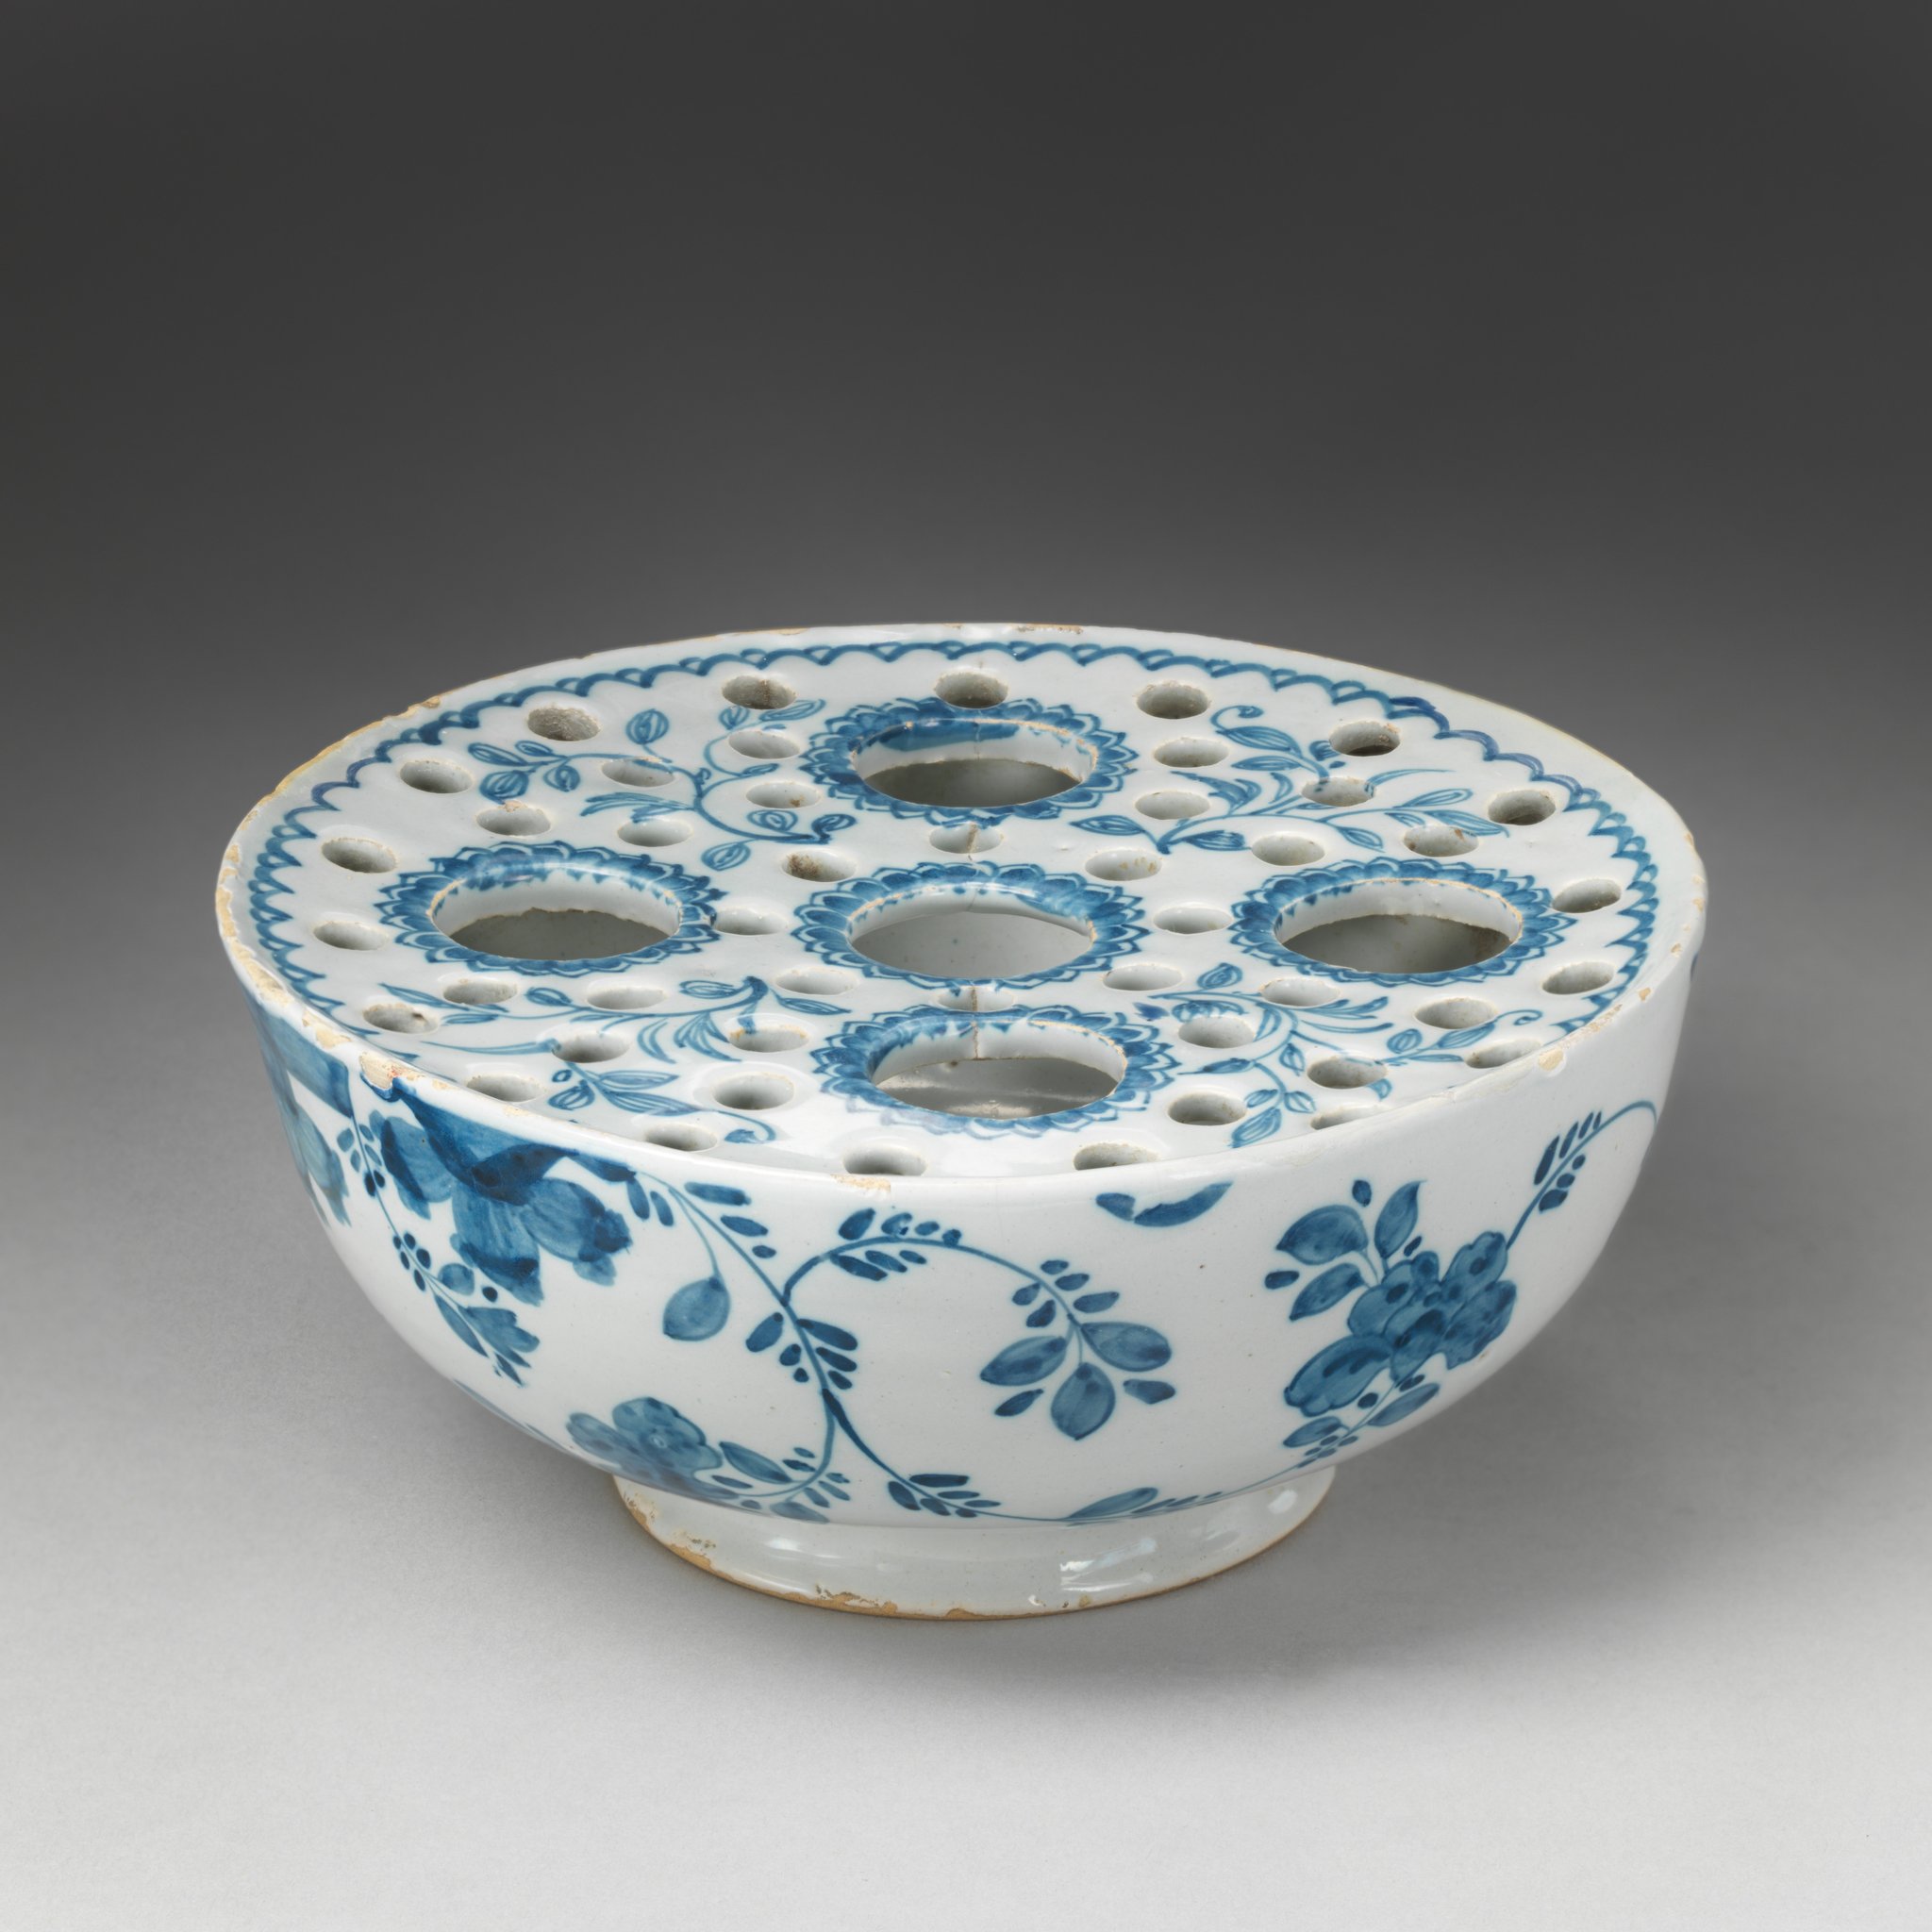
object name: bulb pot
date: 1801-1850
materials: earthenware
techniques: glazing